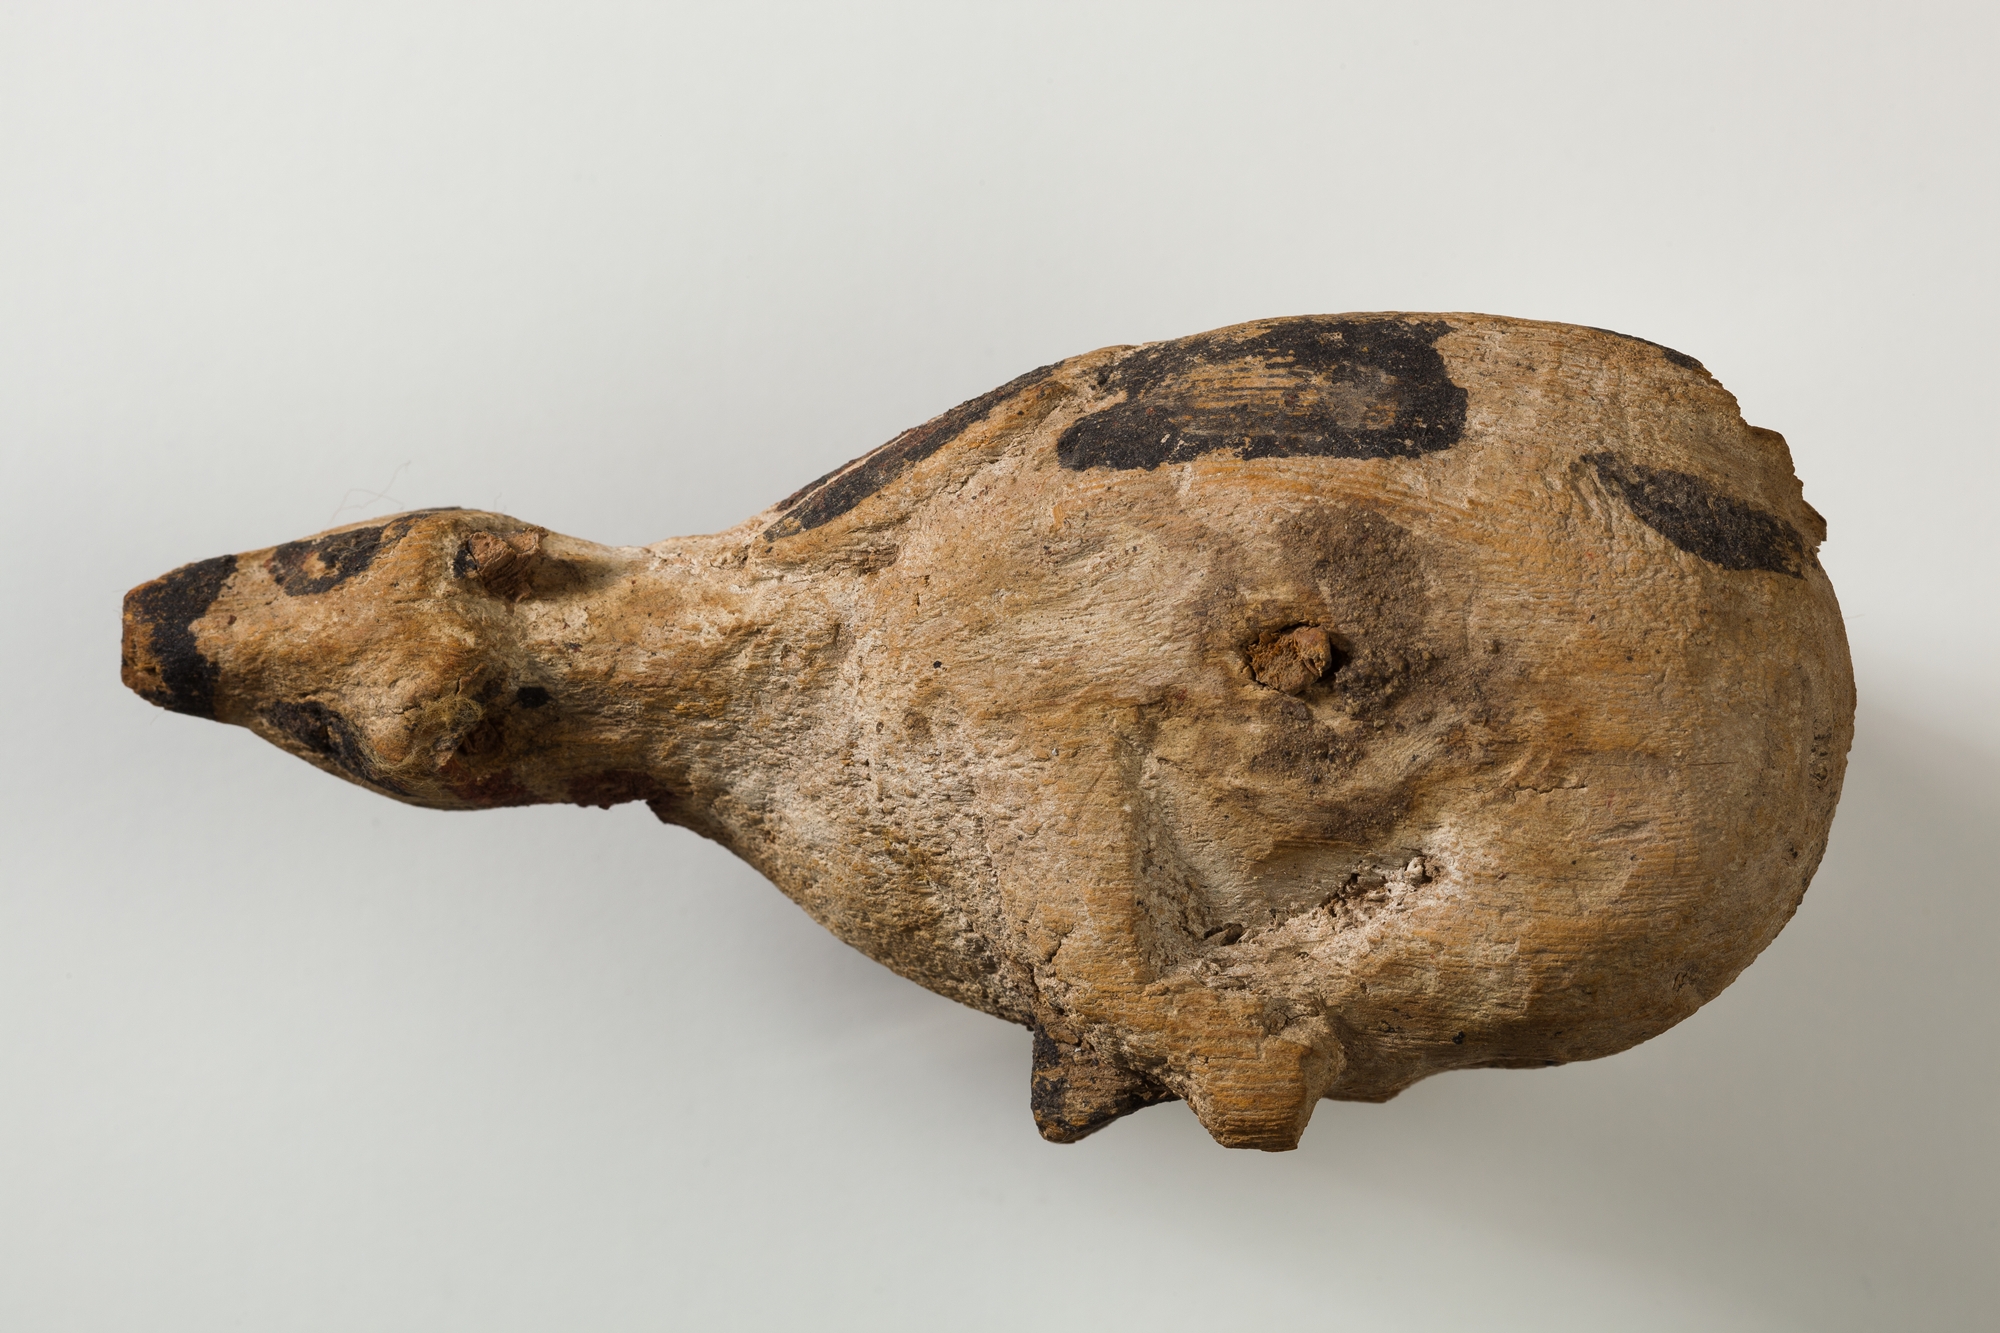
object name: model ox, trussed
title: Model of a trussed ox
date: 2051-2000 BCE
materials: paint, wood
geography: egypt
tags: animals